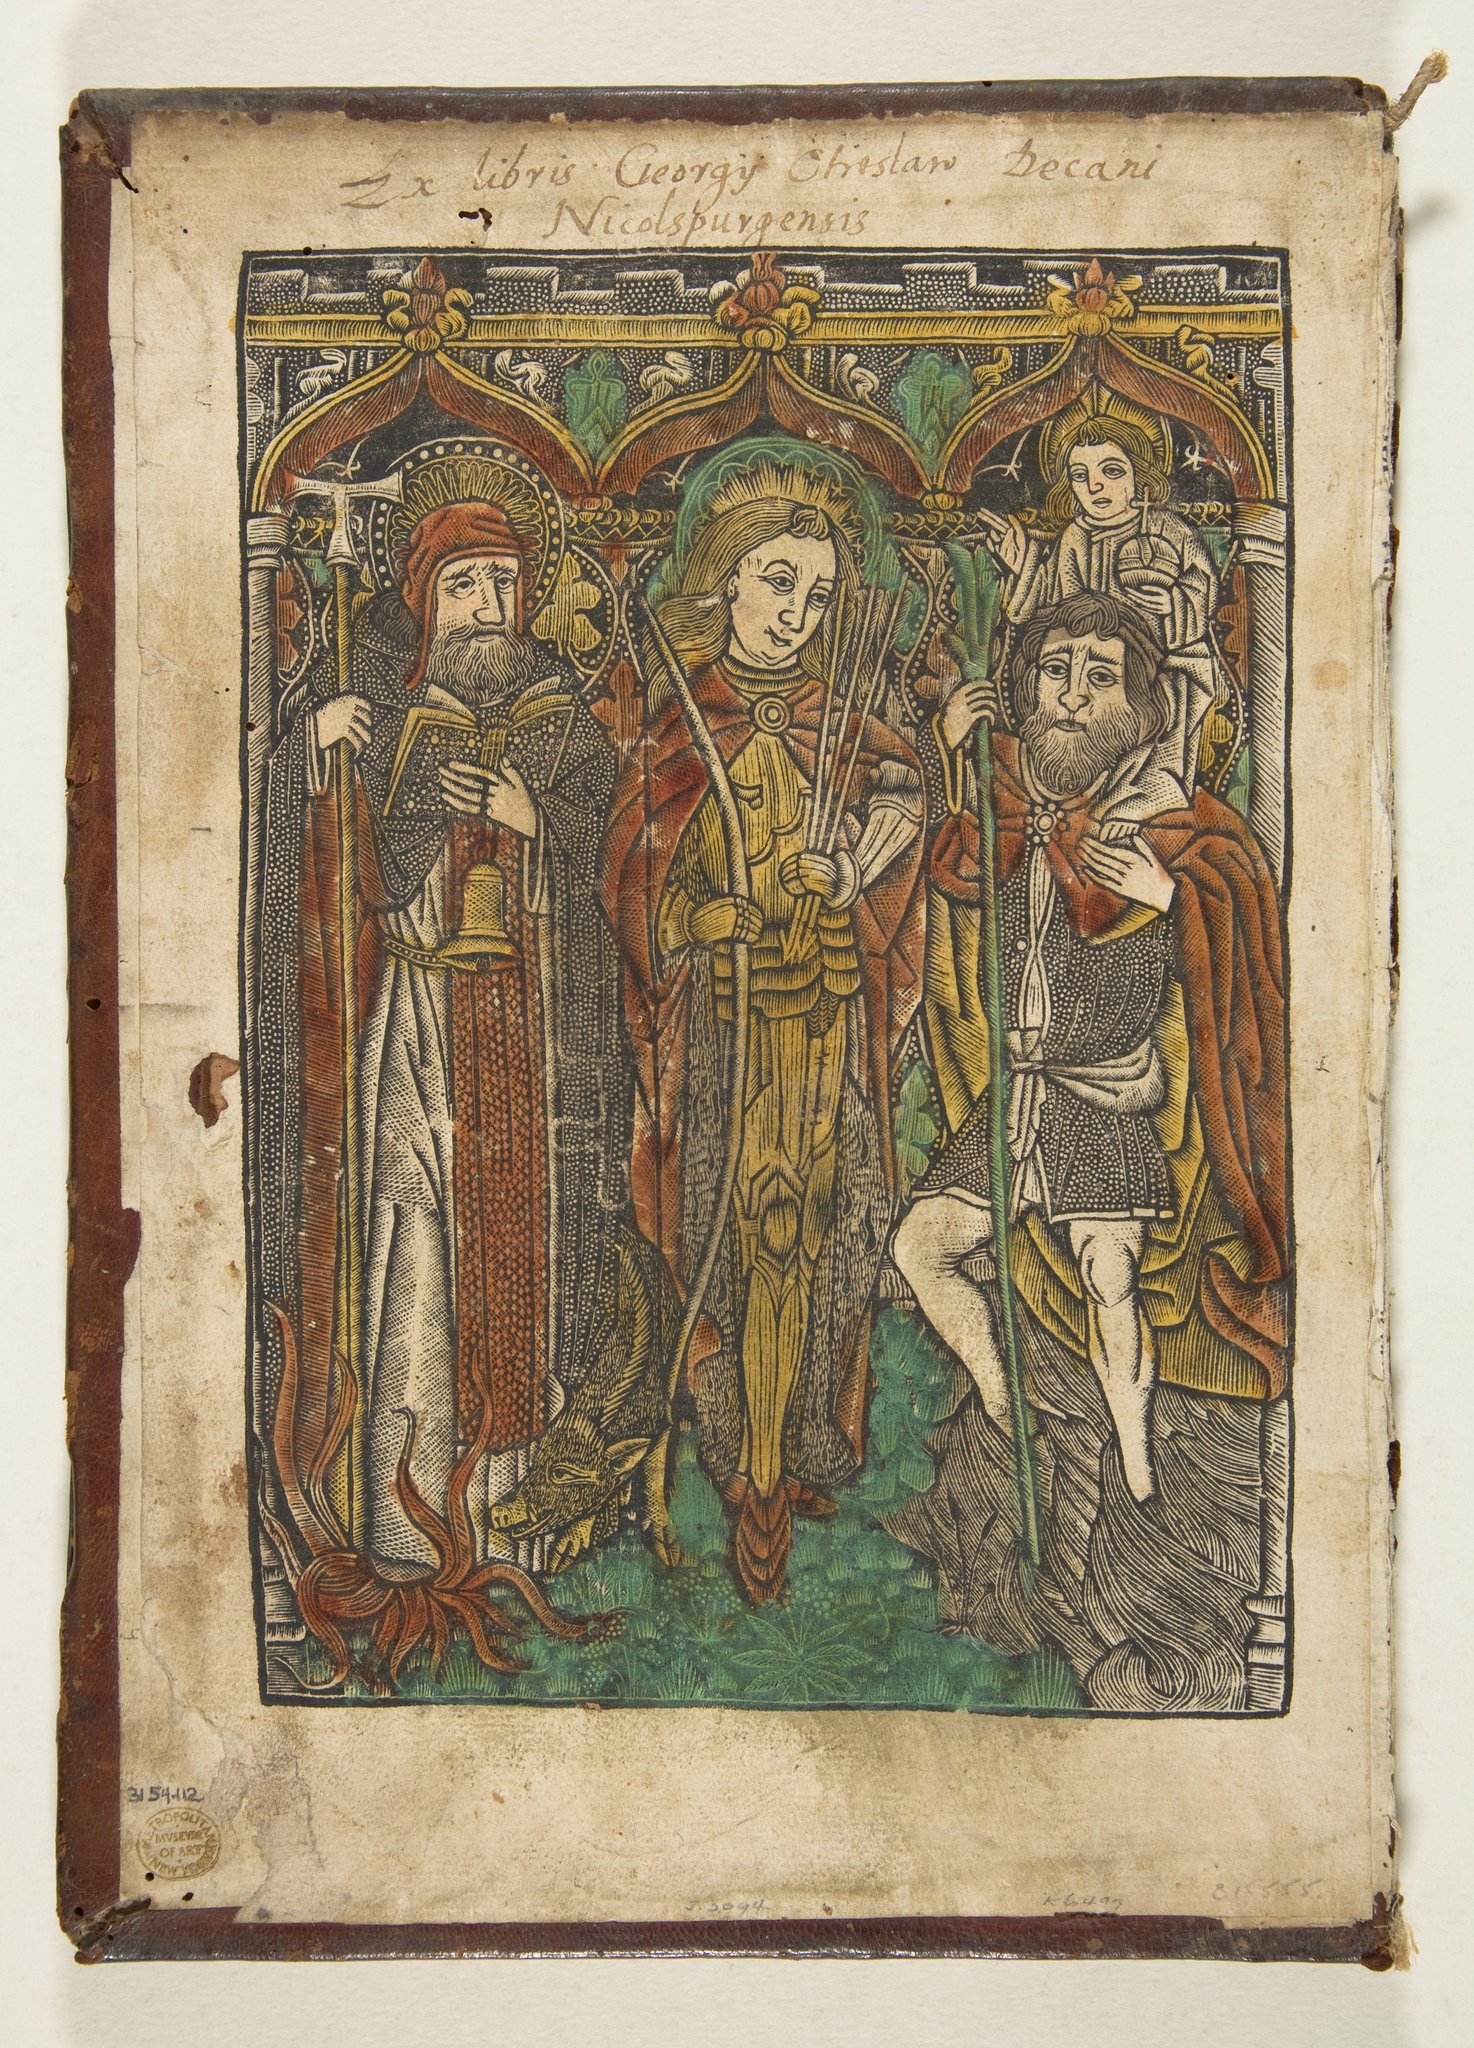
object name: print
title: Saints Anthony, Sebastian and Christopher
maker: anonymous, german, cologne, 15th century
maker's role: artist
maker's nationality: german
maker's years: 1400-1500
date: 1470-1490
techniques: hand coloring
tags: bow and arrow,men,women,saint anthony